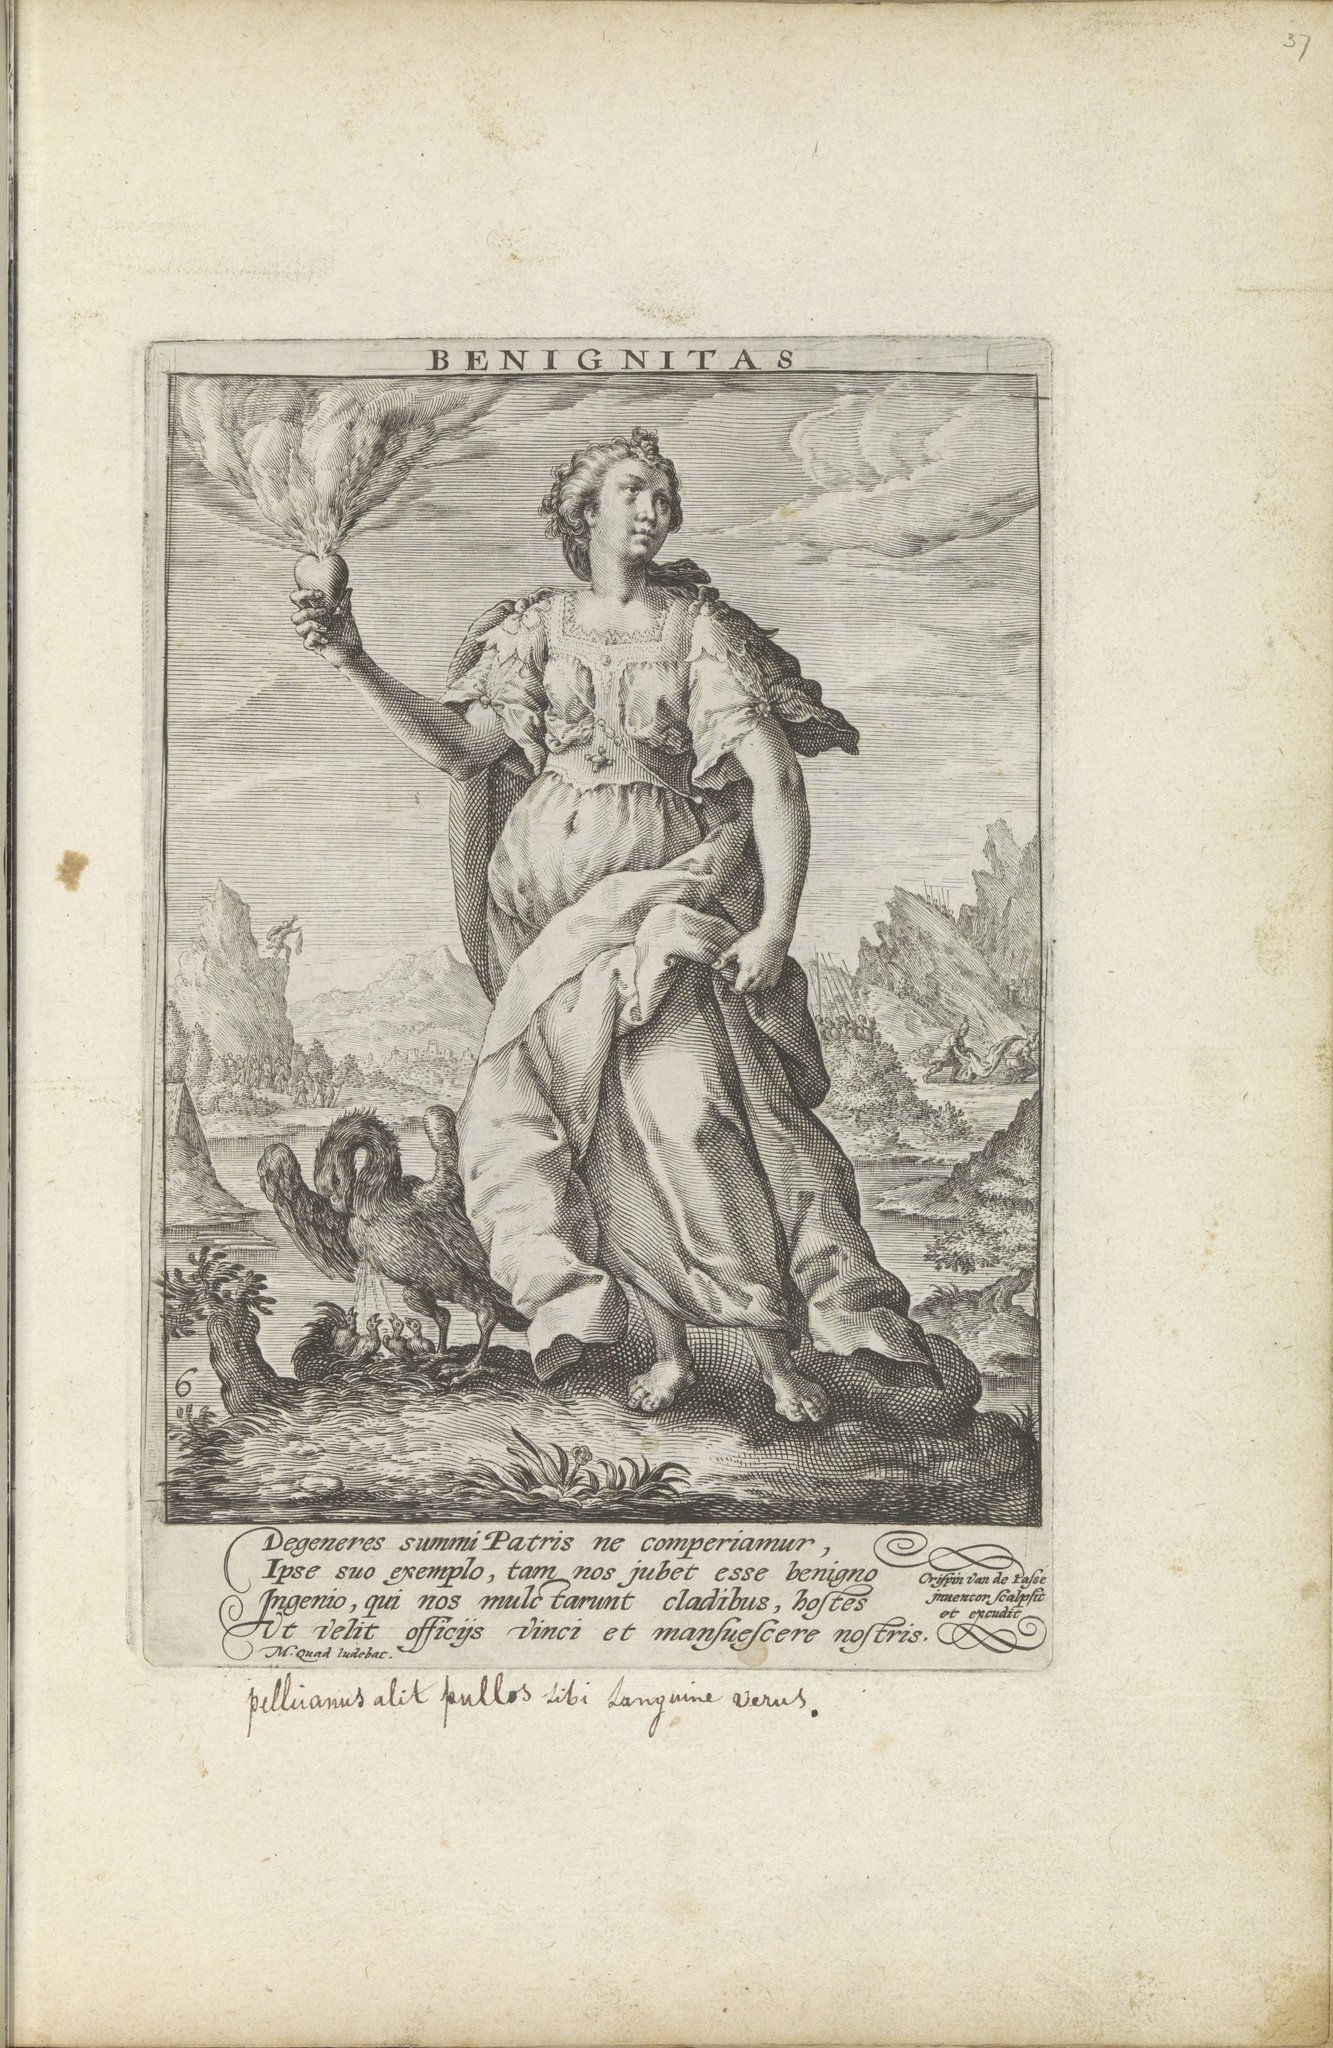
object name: album leaf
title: Deugden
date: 1589-1611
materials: paper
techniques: engraving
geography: cologne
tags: david cuts off a piece of saul's robe, saul and david in the same cave; saul relieving himself, friendliness, gentleness, affability; 'affabilità, piacevolezza, amabilità', 'animo piacevole, trattabile & amorevole', 'benignità' (ripa) (+ personification), when saul comes out of the cave, david calls him, falls down on his knees and shows him the piece of cloth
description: De personificatie van Goedheid staat in een landschap met een brandend hart in de hand. Aan haar voeten staat de pelikaan, die zich de borst doorboort om zijn jongen met zijn bloed te voeden. Op de achtergrond rechts benadert David zijn vijand koning Saul, terwijl deze hurkend zijn behoefte doet. David kan Saul doden, maar neemt alleen een stuk van zijn mantel mee. Links toont David het stuk mantel vanaf een rots aan Saul. Hiermee bewijst David zijn goedheid jegens Saul. Onder de voorstelling een vierregelig vers in het Latijn. Deze prent maakt deel uit van een album.